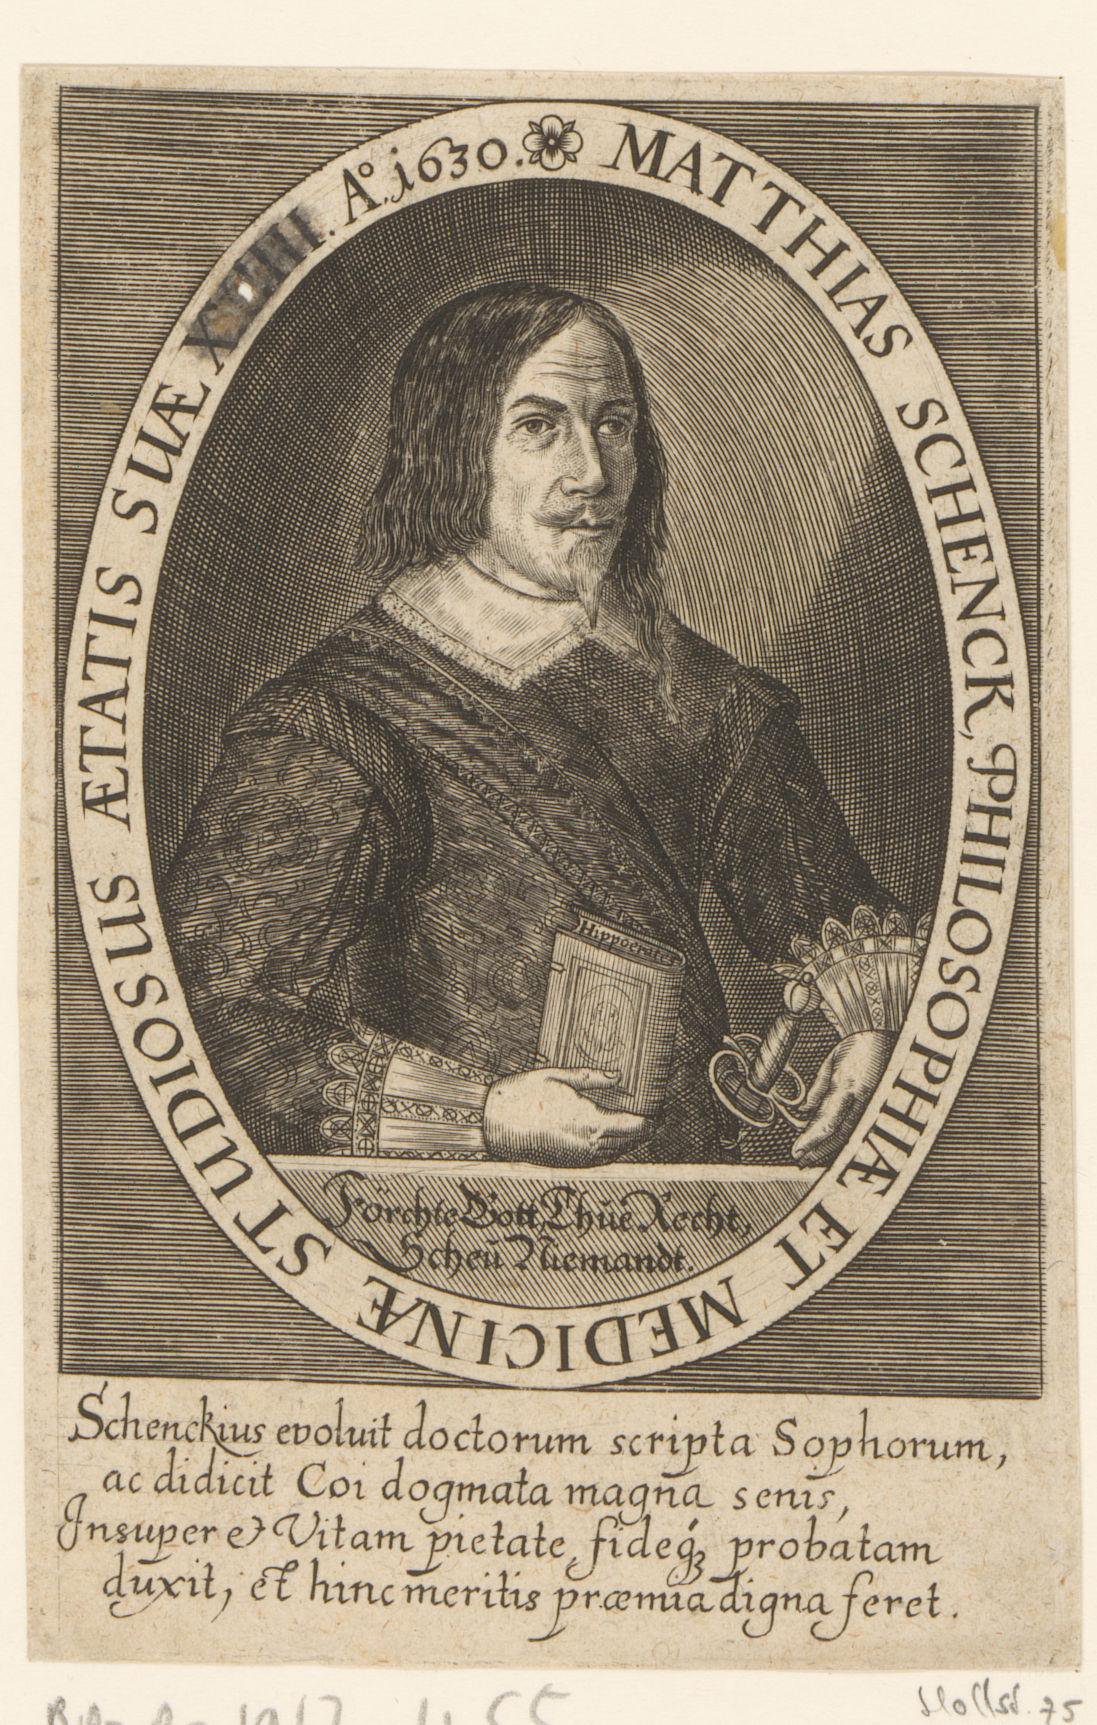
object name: print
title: Portret van Matthias Schenk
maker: johann pfann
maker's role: print maker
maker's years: 1640-1680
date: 1648-1663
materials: paper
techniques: engraving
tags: historical persons, hacking and thrusting weapons: sword, book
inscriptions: collector's mark: Lugt 2228